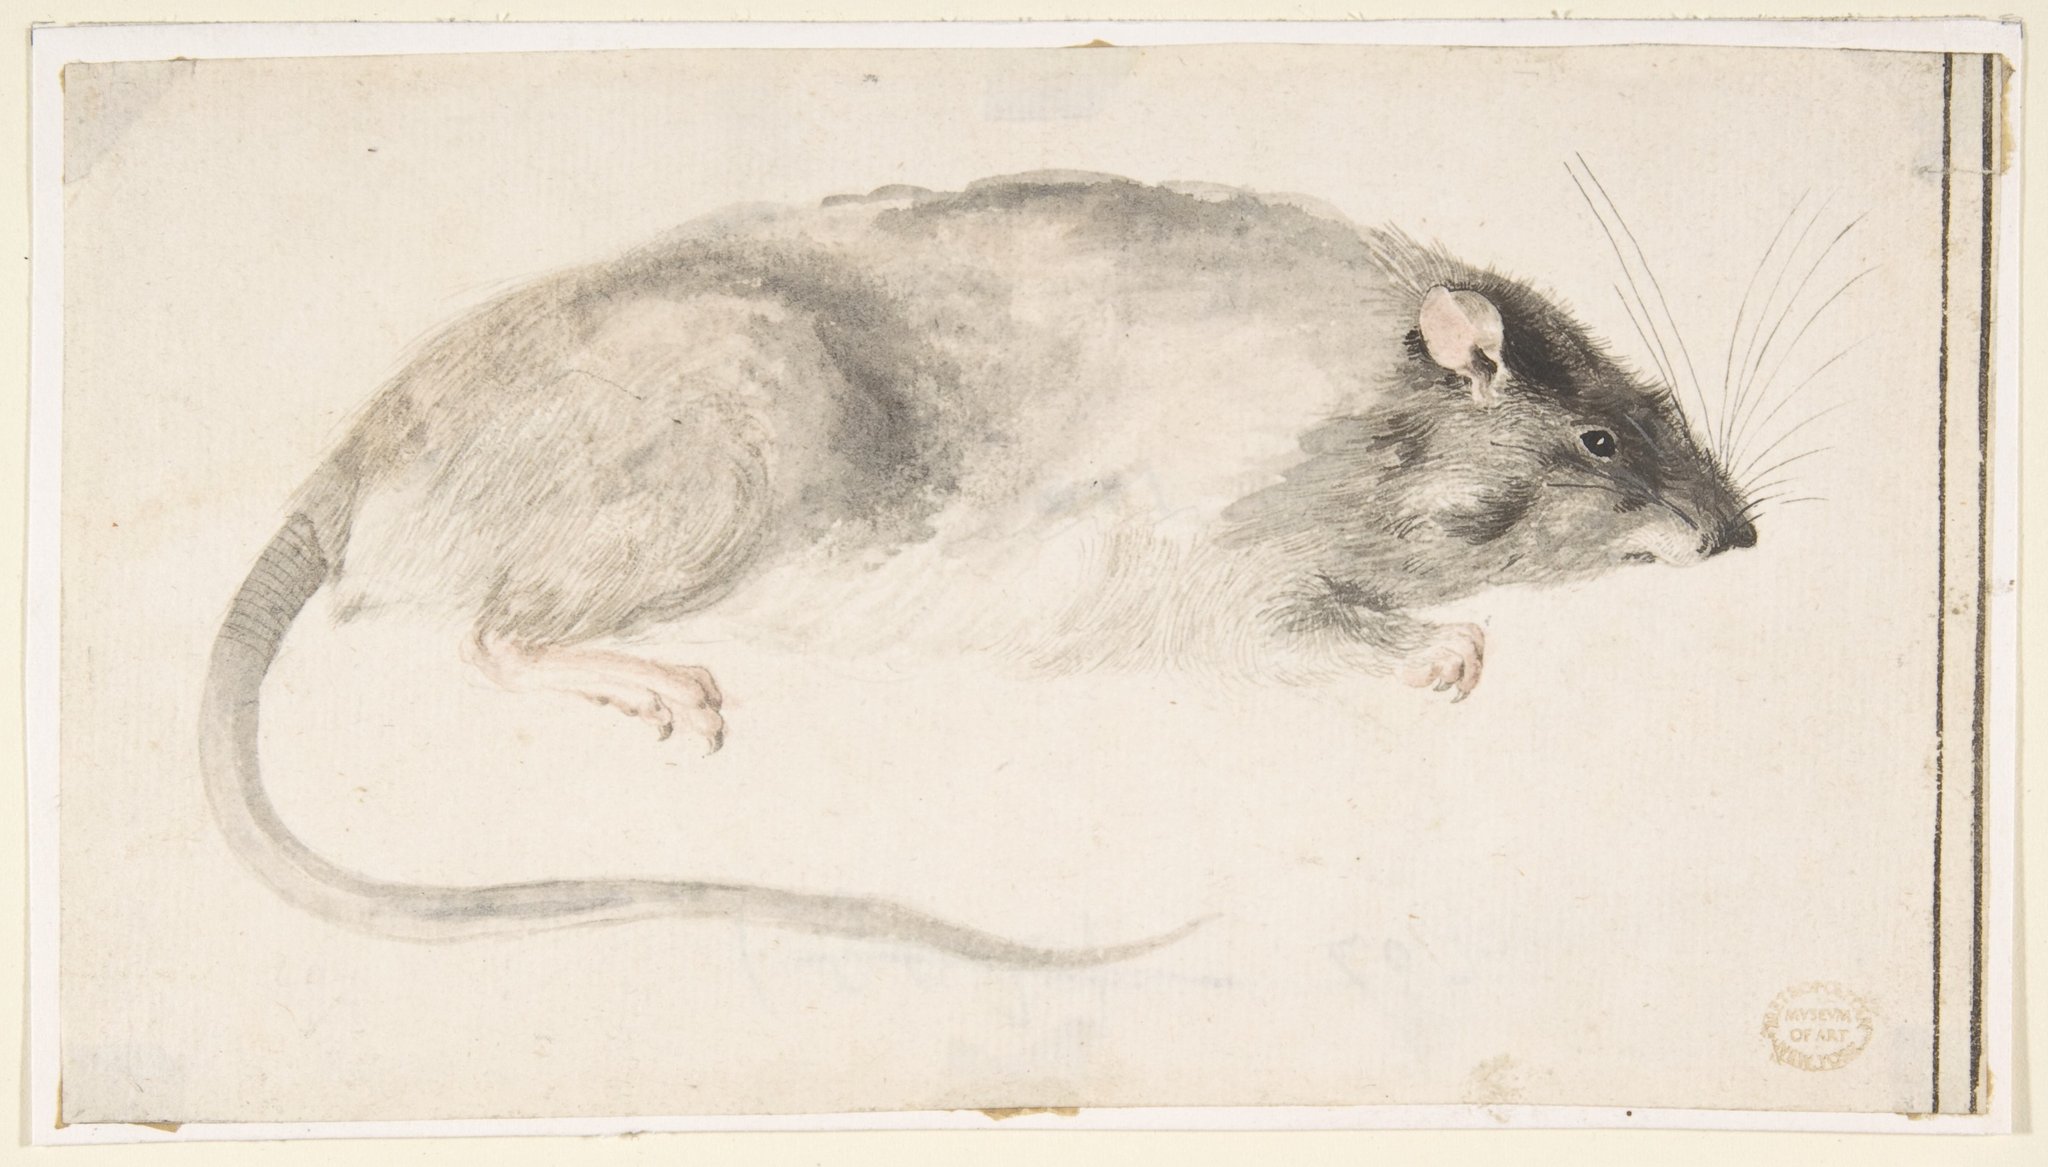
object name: drawing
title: A Rat Seen in Profile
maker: count giorgio durante (duranti)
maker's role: artist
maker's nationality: italian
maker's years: 1685-1755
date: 1685-1755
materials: graphite, ink, watercolor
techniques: pen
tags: rats